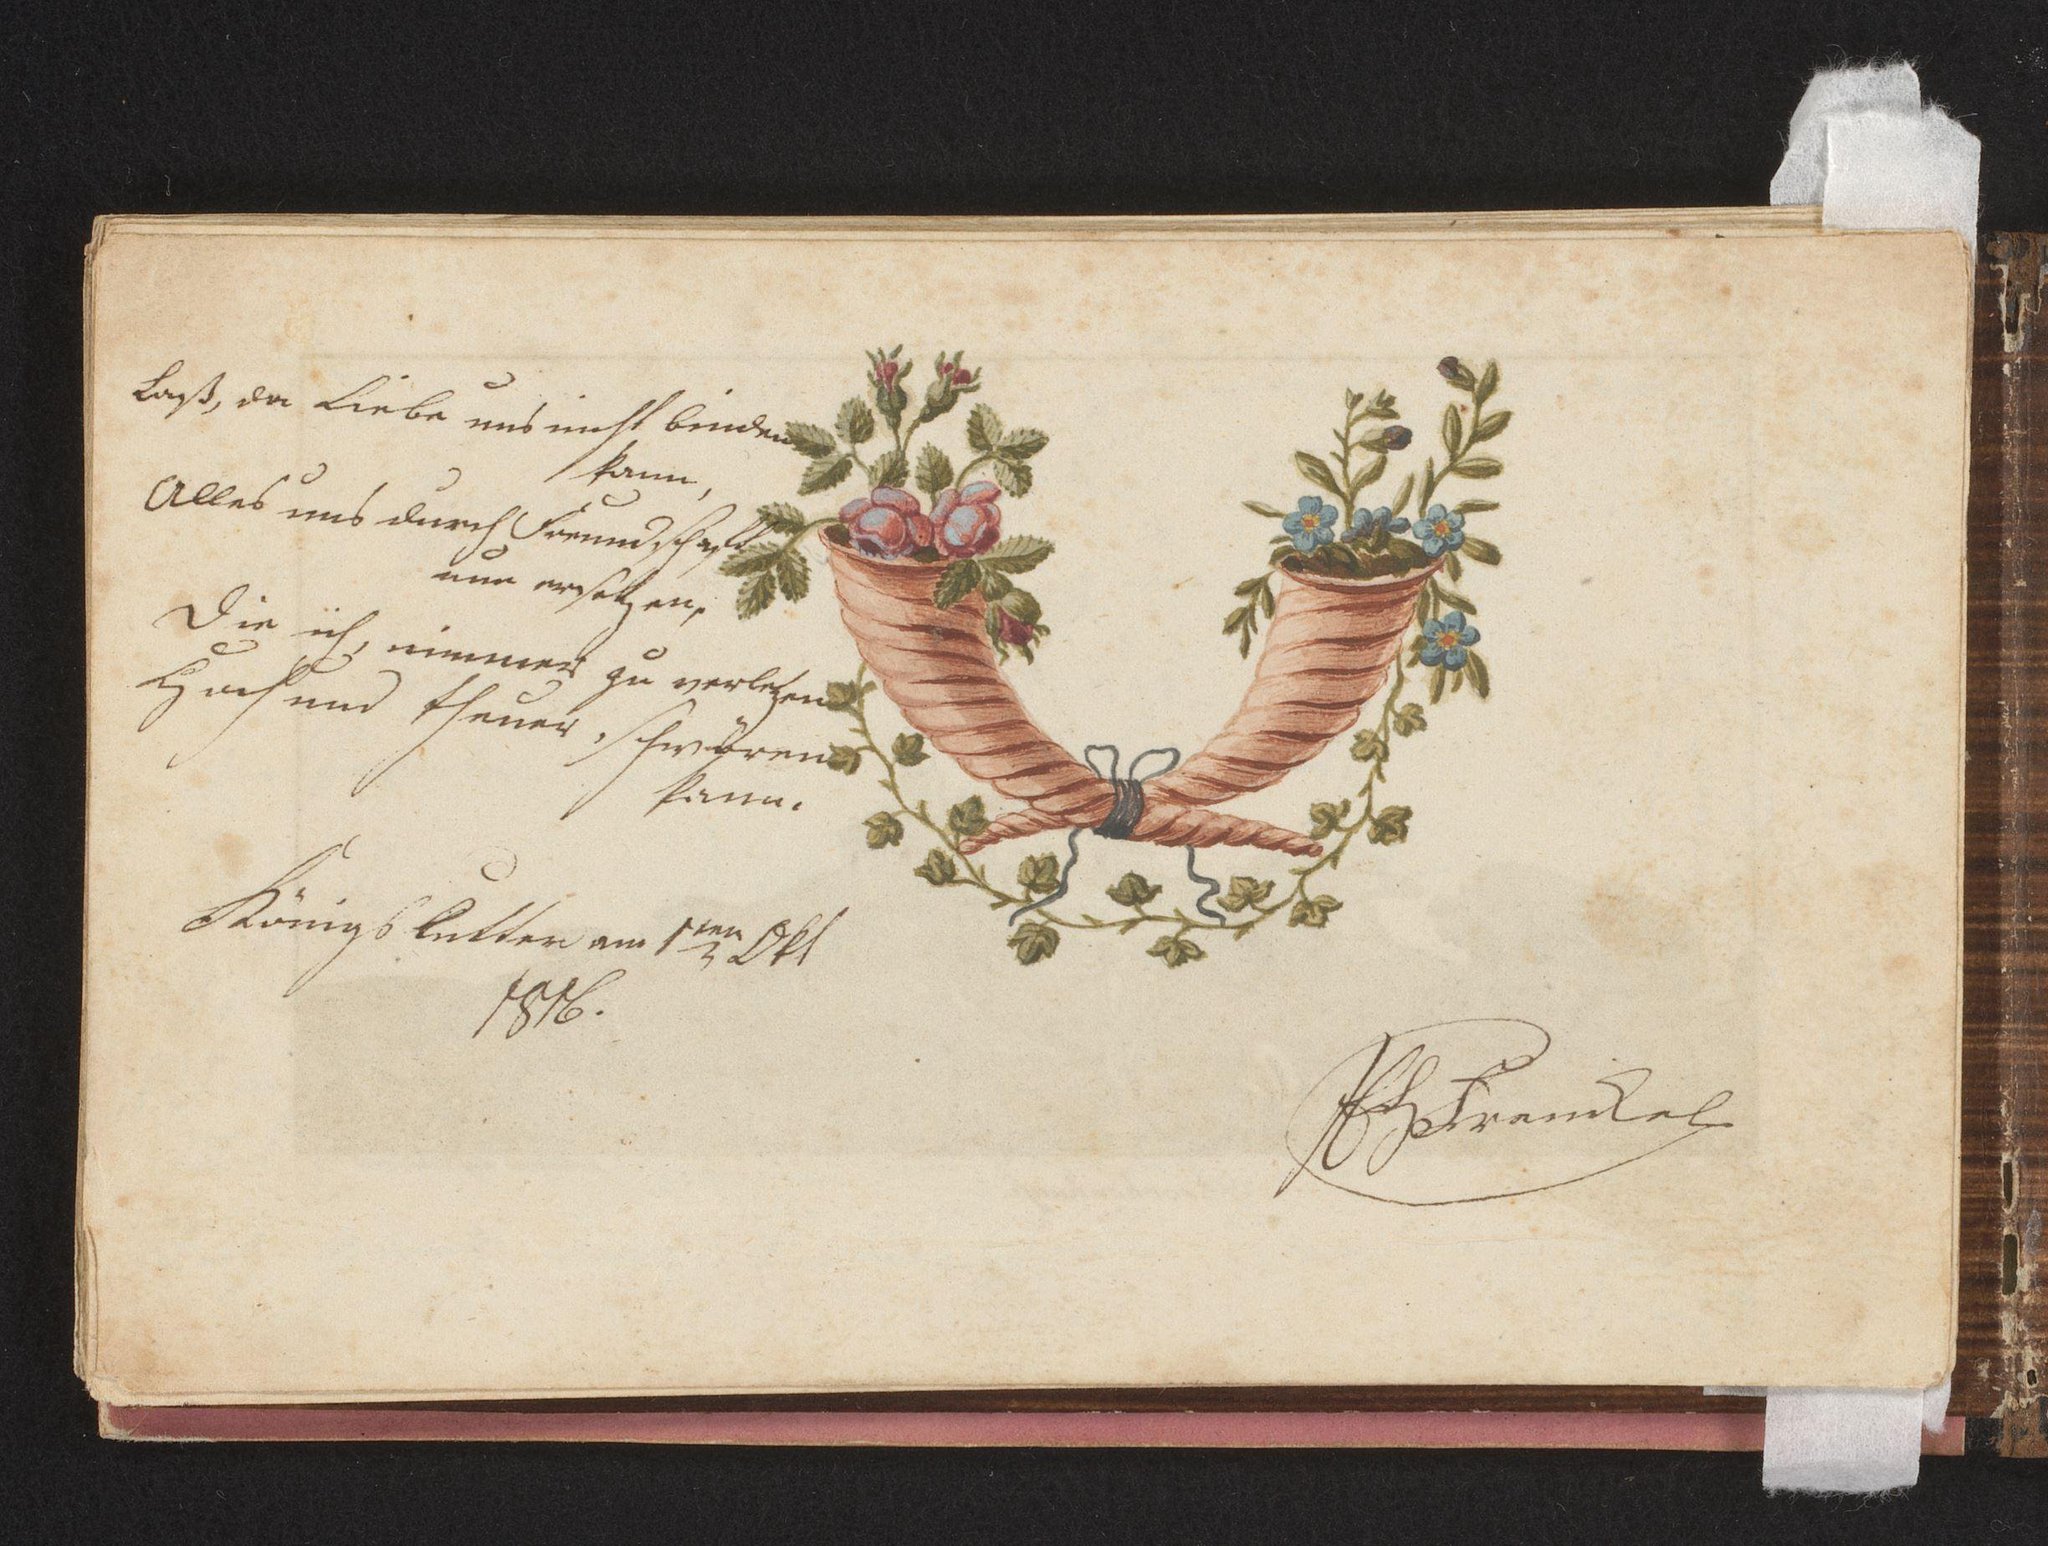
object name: print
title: Tekst en twee hoorns gevuld met vergeet-me-nietjes en rozen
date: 1770-1816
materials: paint, ink, paper, watercolor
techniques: brush, writing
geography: gottingen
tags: 'cornucopia', horn of plenty, floral interlace ~ ornament, 'album amicorum', 'stammbuch'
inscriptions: tekst, verso, handgeschreven